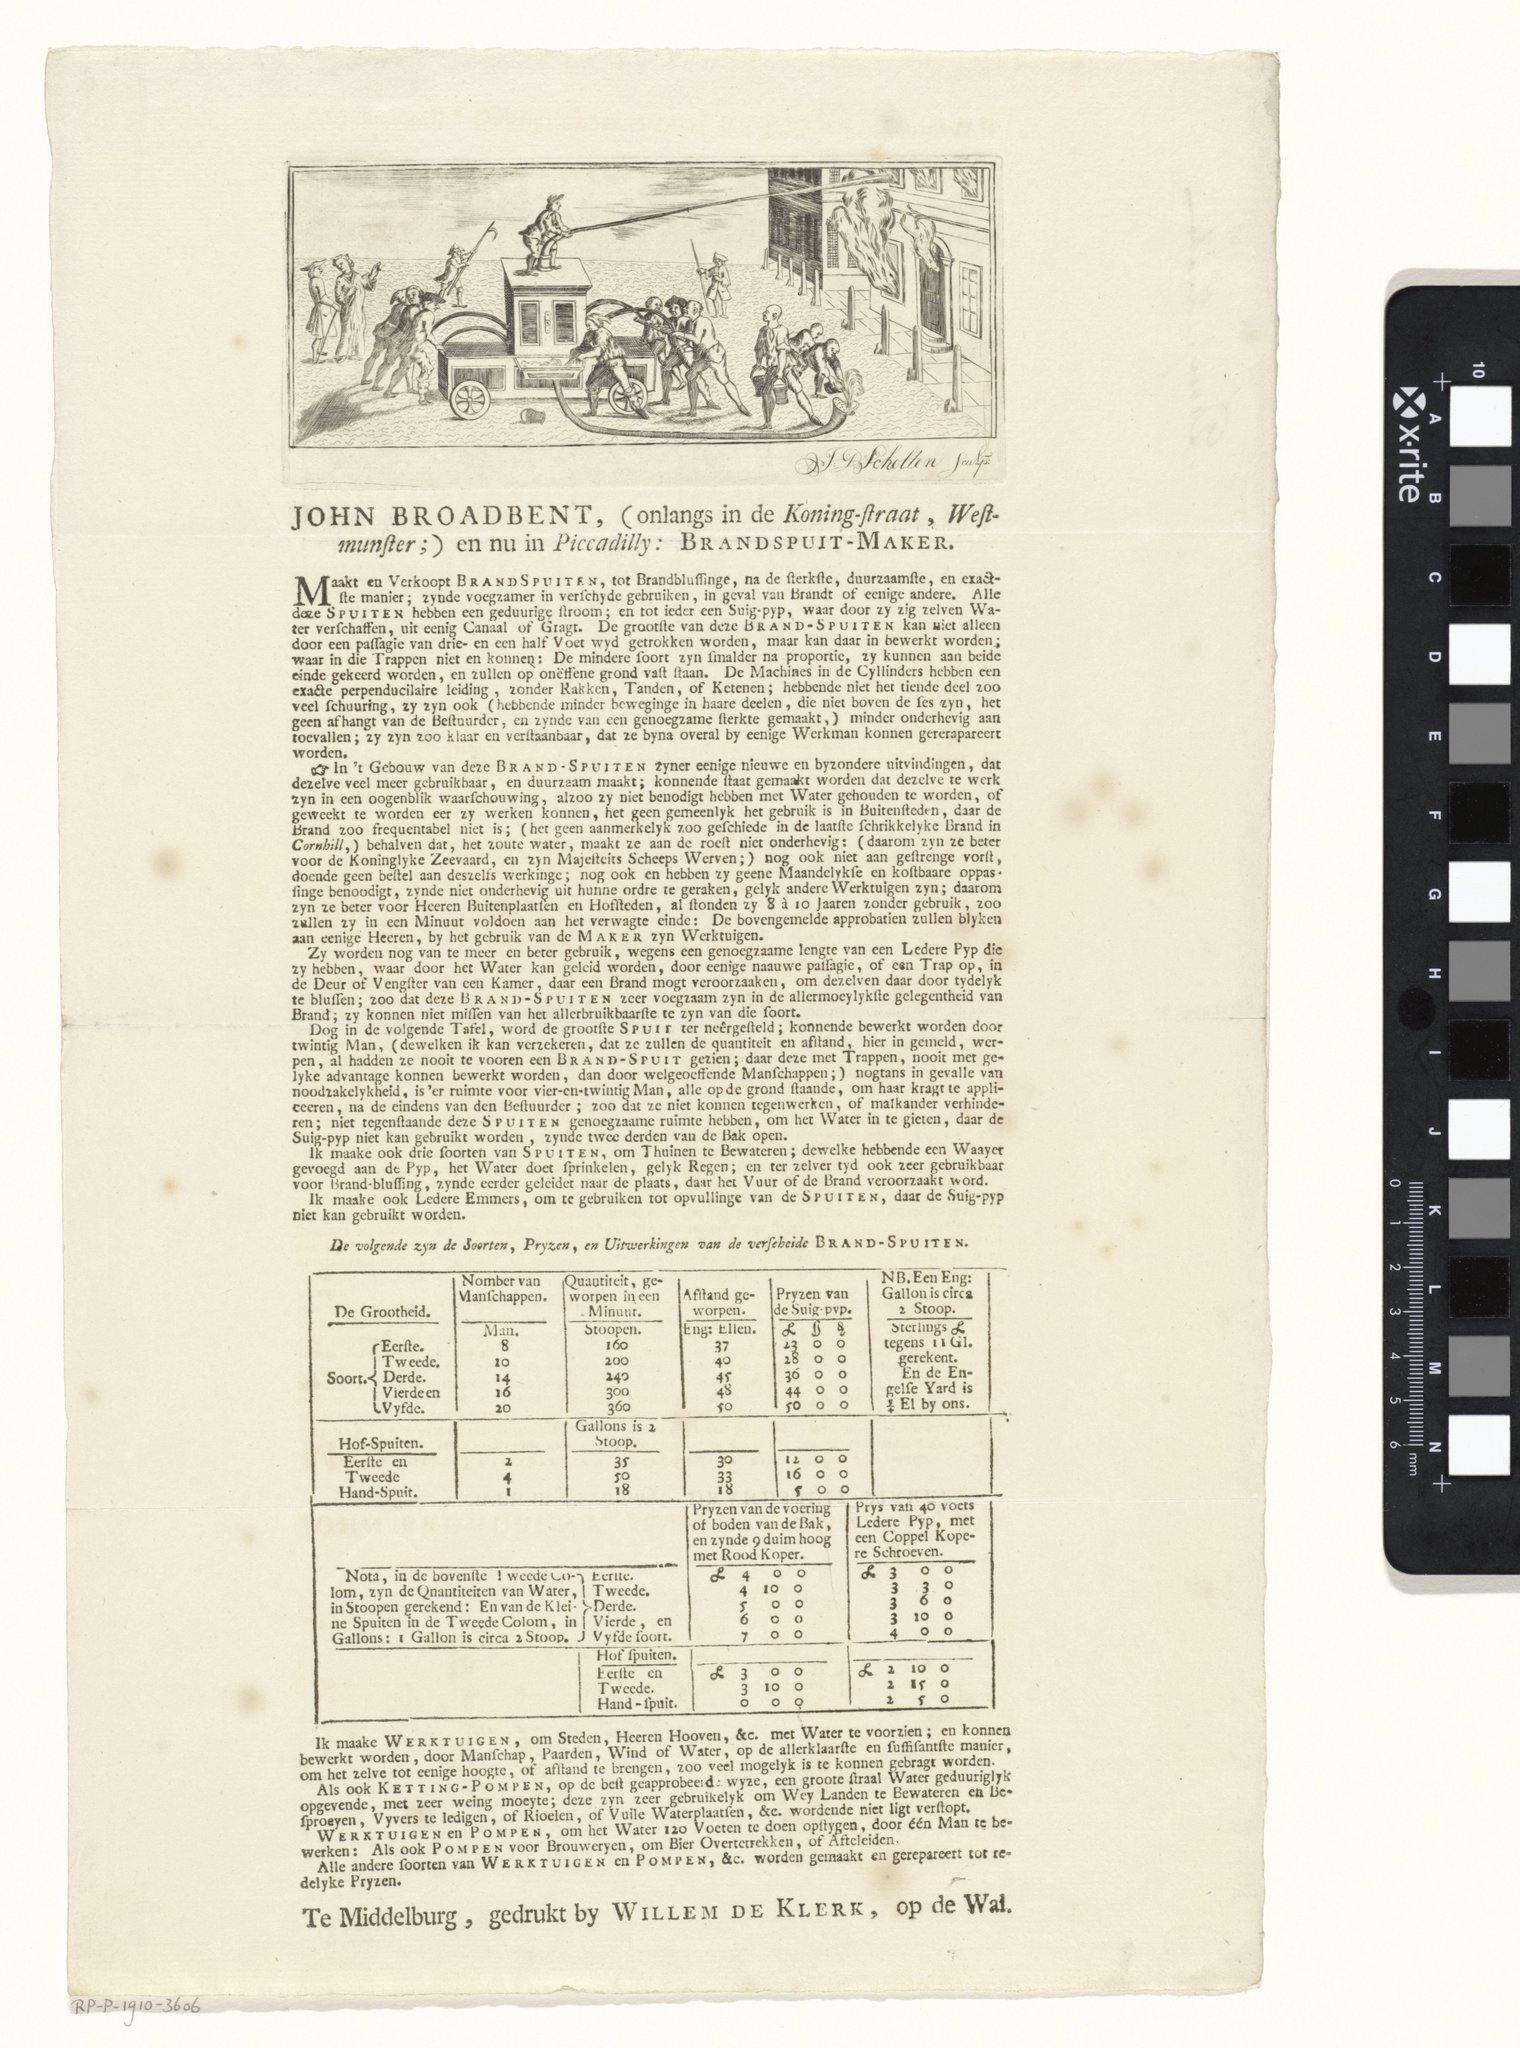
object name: print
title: Advertentie van John Broadbent, brandspuitmaker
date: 1730-1760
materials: paper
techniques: etching, letterpress printing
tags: fire-hose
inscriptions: collector's mark: Lugt 2228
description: Mannen storten emmers water in een reservoir van een brandspuit en in de zuigpijp. Zes anderen bedienen de pomp, terwijl een zevende man vanaf het dak de brandslang op een brandend huis richt. Voorbijgangers kijken toe. Onder de prent een beschrijving en aanprijzing van de door John Broadbent ontwikkelde brandspuiten en andere waterpompen.